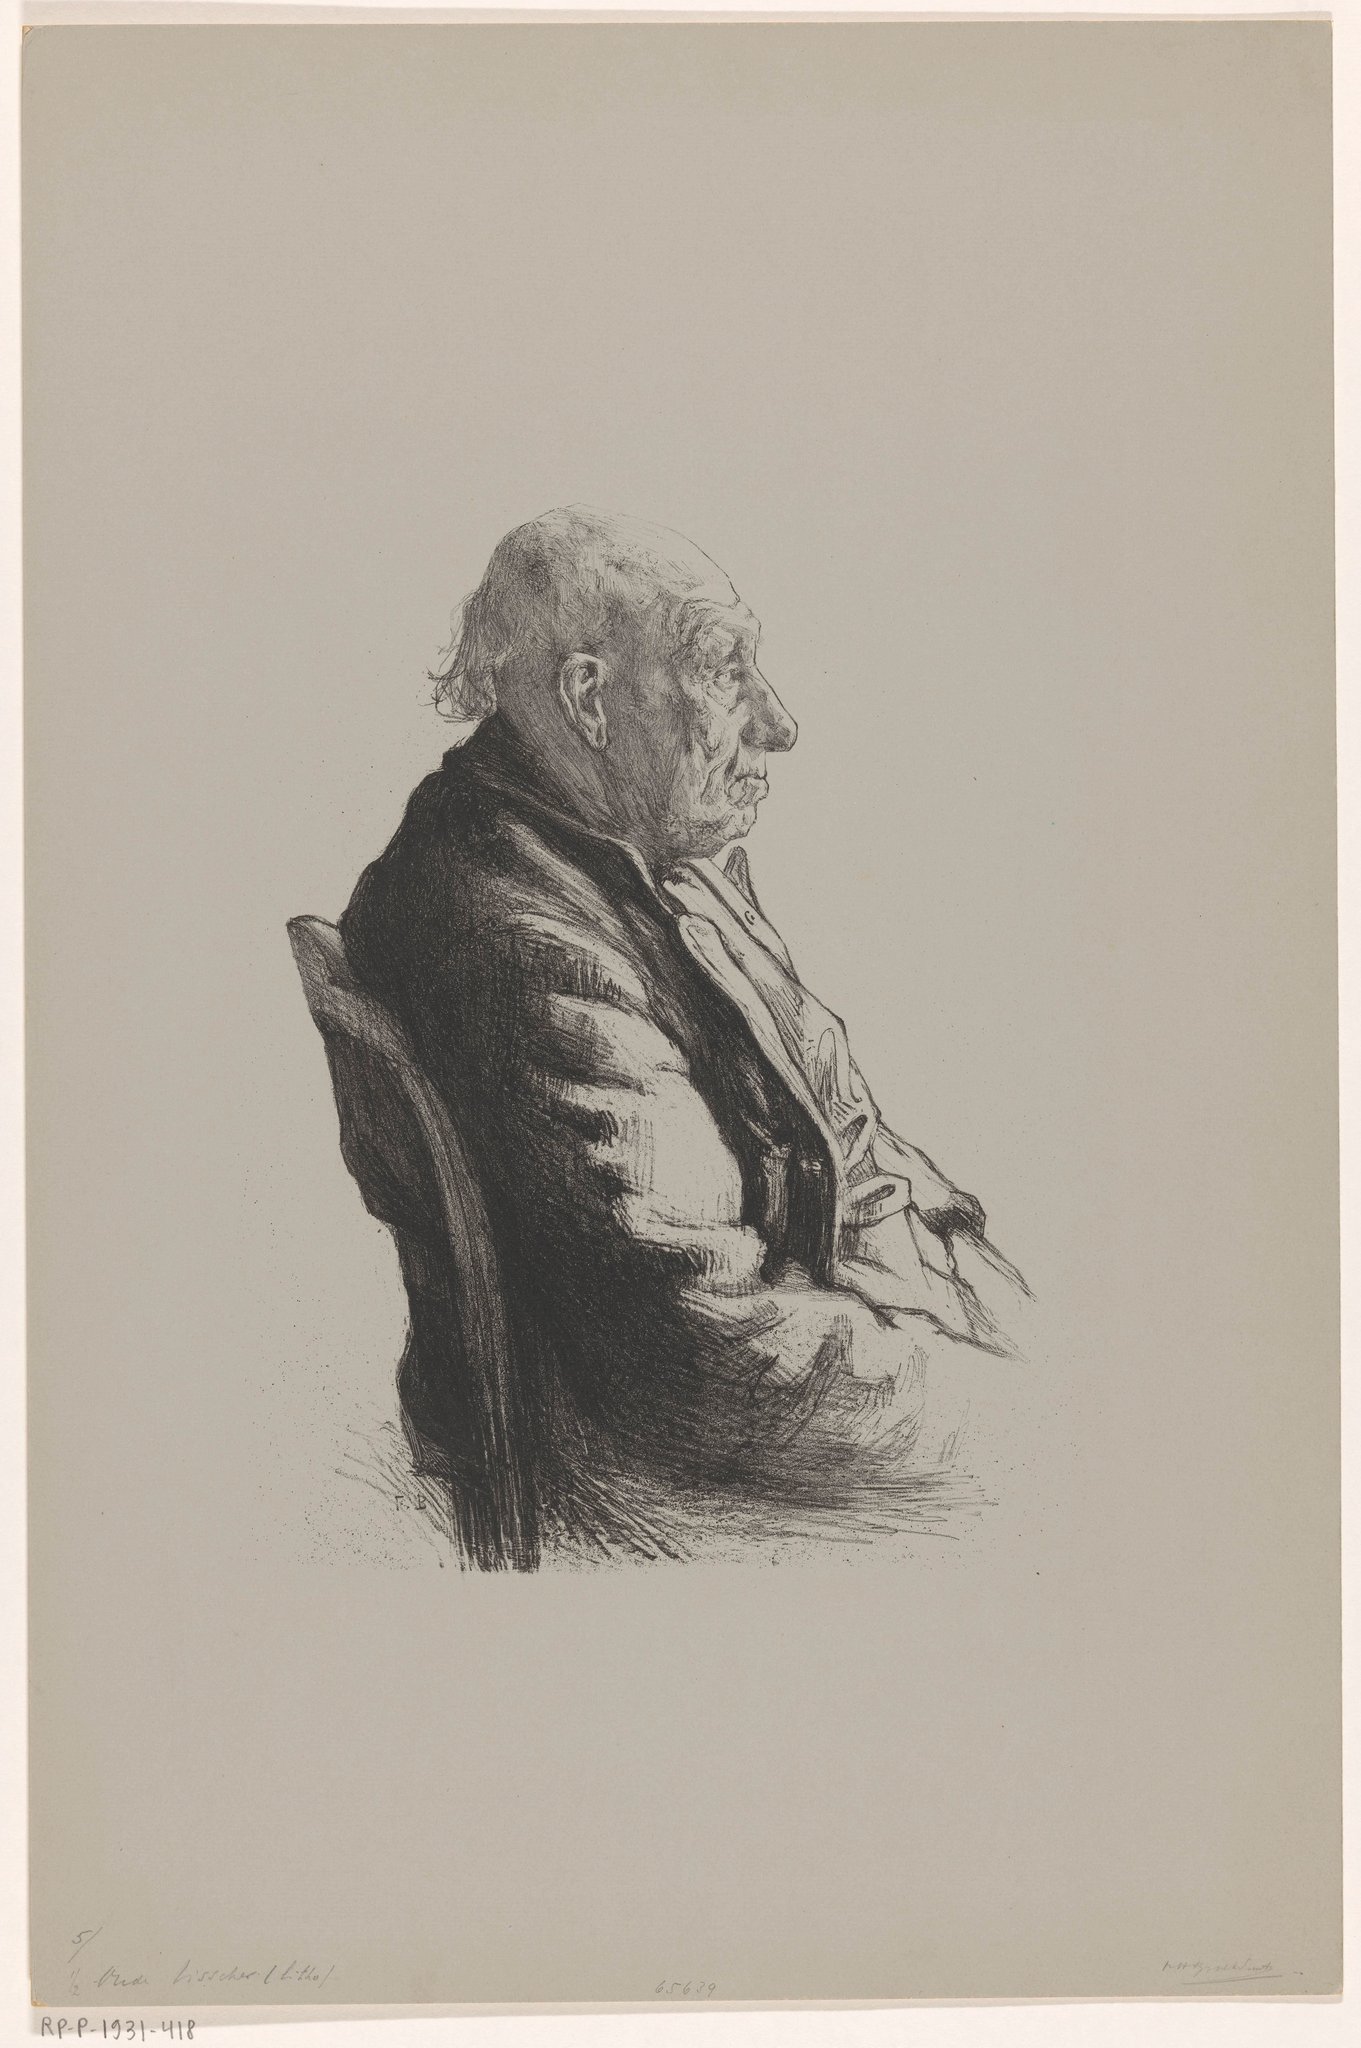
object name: print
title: Oude visscher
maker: frederika henriëtte broeksmit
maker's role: draughtsman, print maker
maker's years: 1875-1945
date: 1905-1908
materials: cardboard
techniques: lithograph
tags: historical persons, fisherman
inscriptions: collector's mark: Lugt 2228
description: Portret van een oude visser uit Katwijk, waarschijnlijk A. Kuyt of Aai Bouwe (1826-1908). Zie ook RP-P-1931-419.